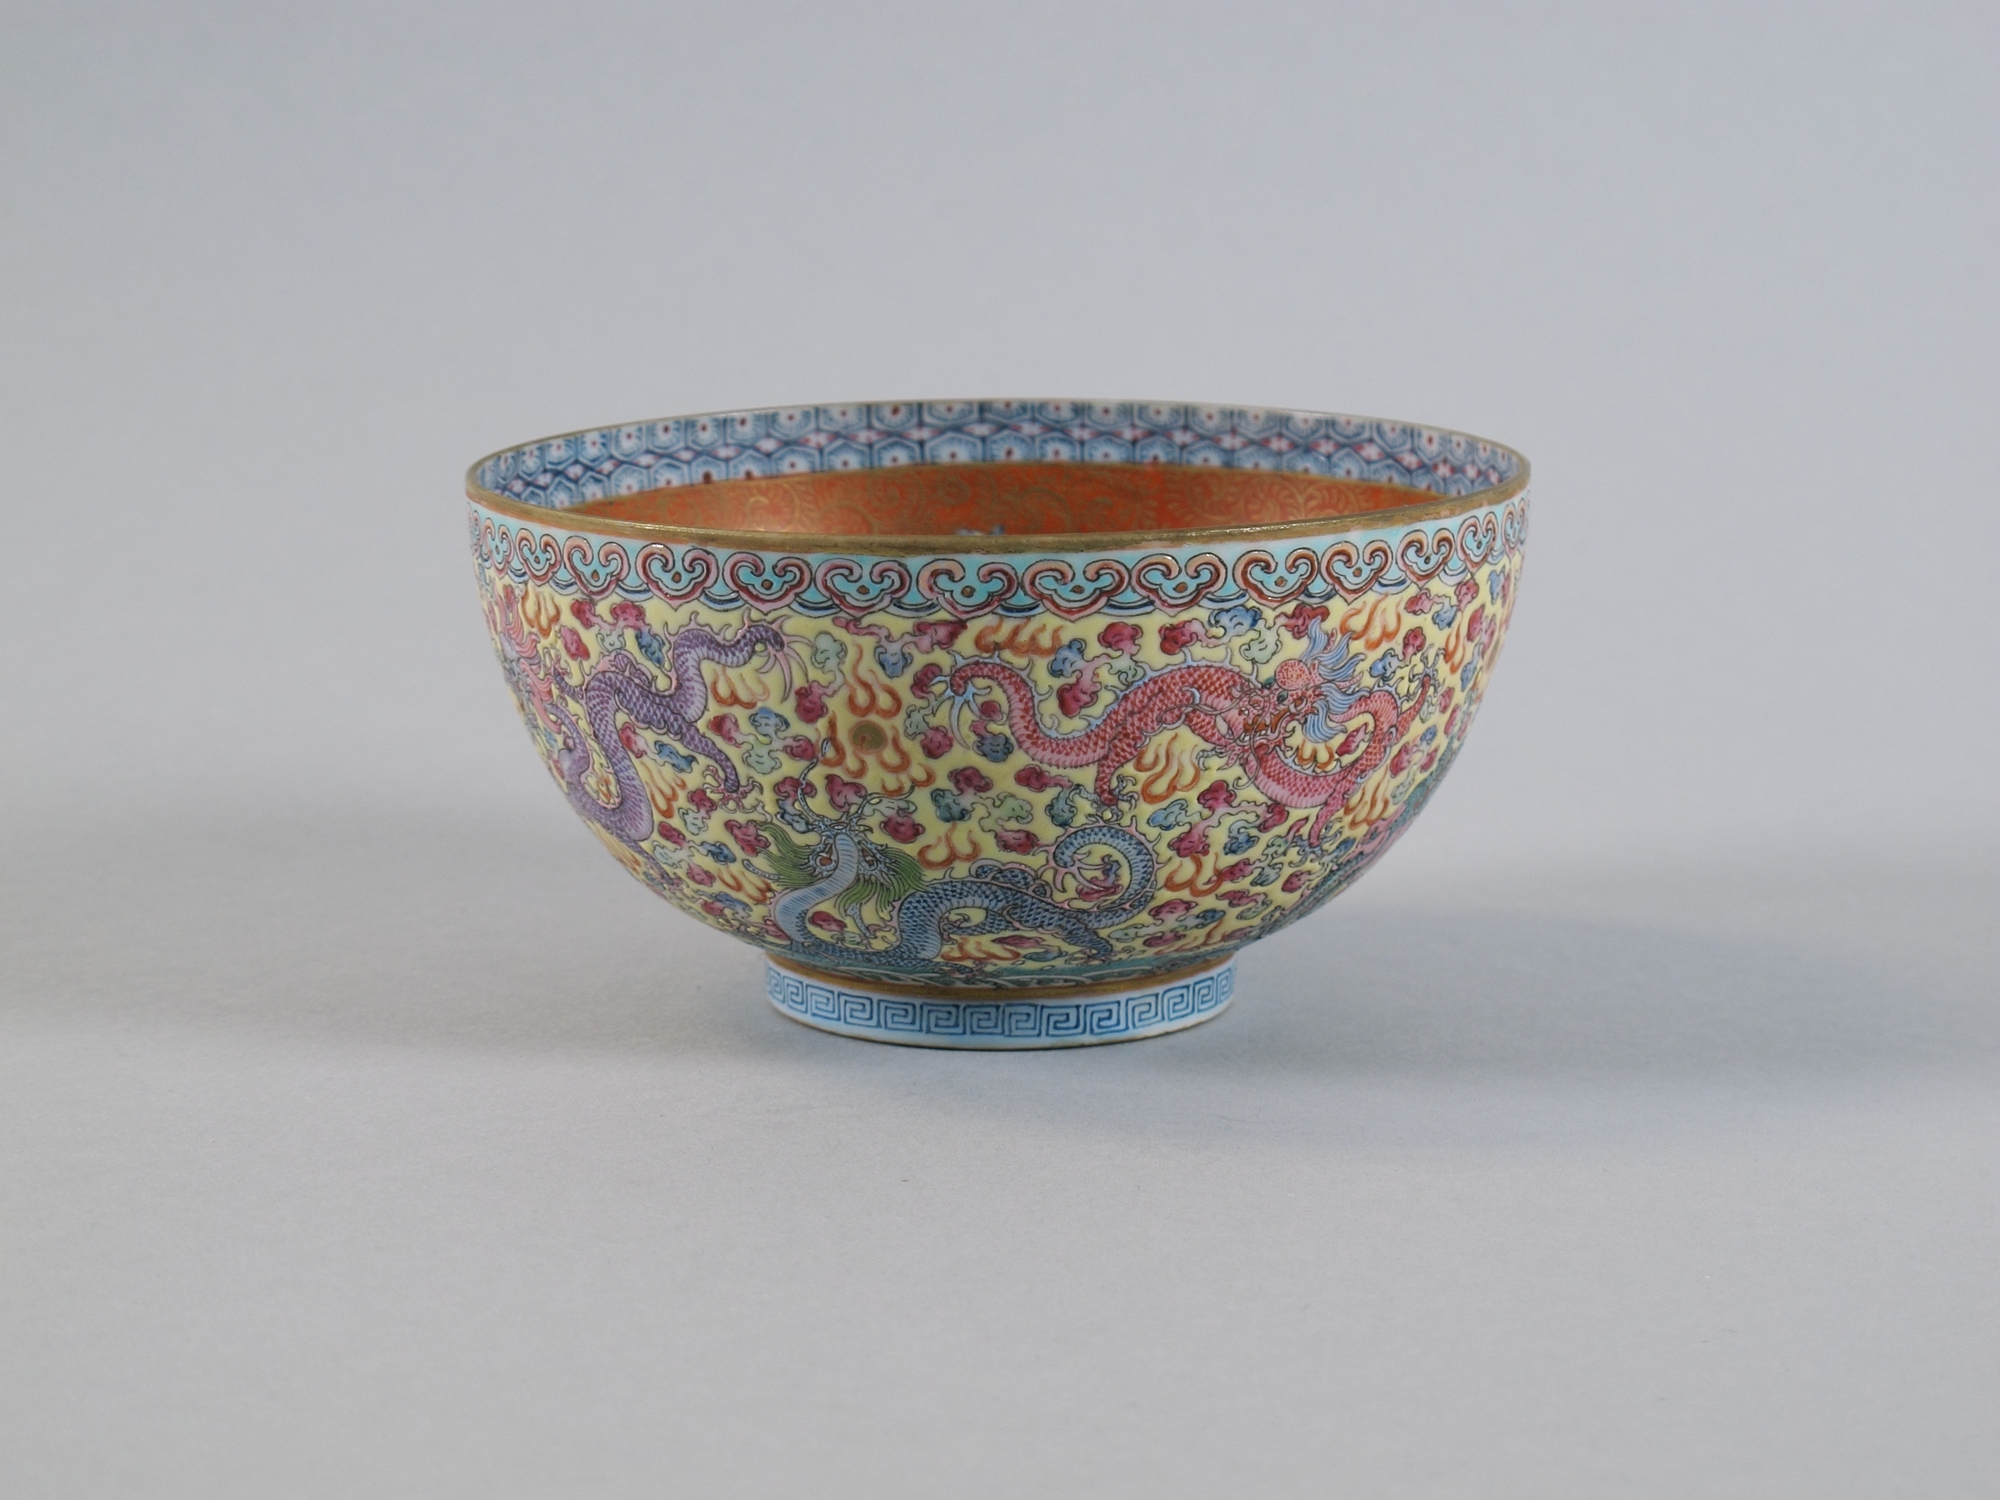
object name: bowl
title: Bowl with dragons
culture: chinese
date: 1901-1950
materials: enamel, porcelain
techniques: overglaze, painting, polychrome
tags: dragons